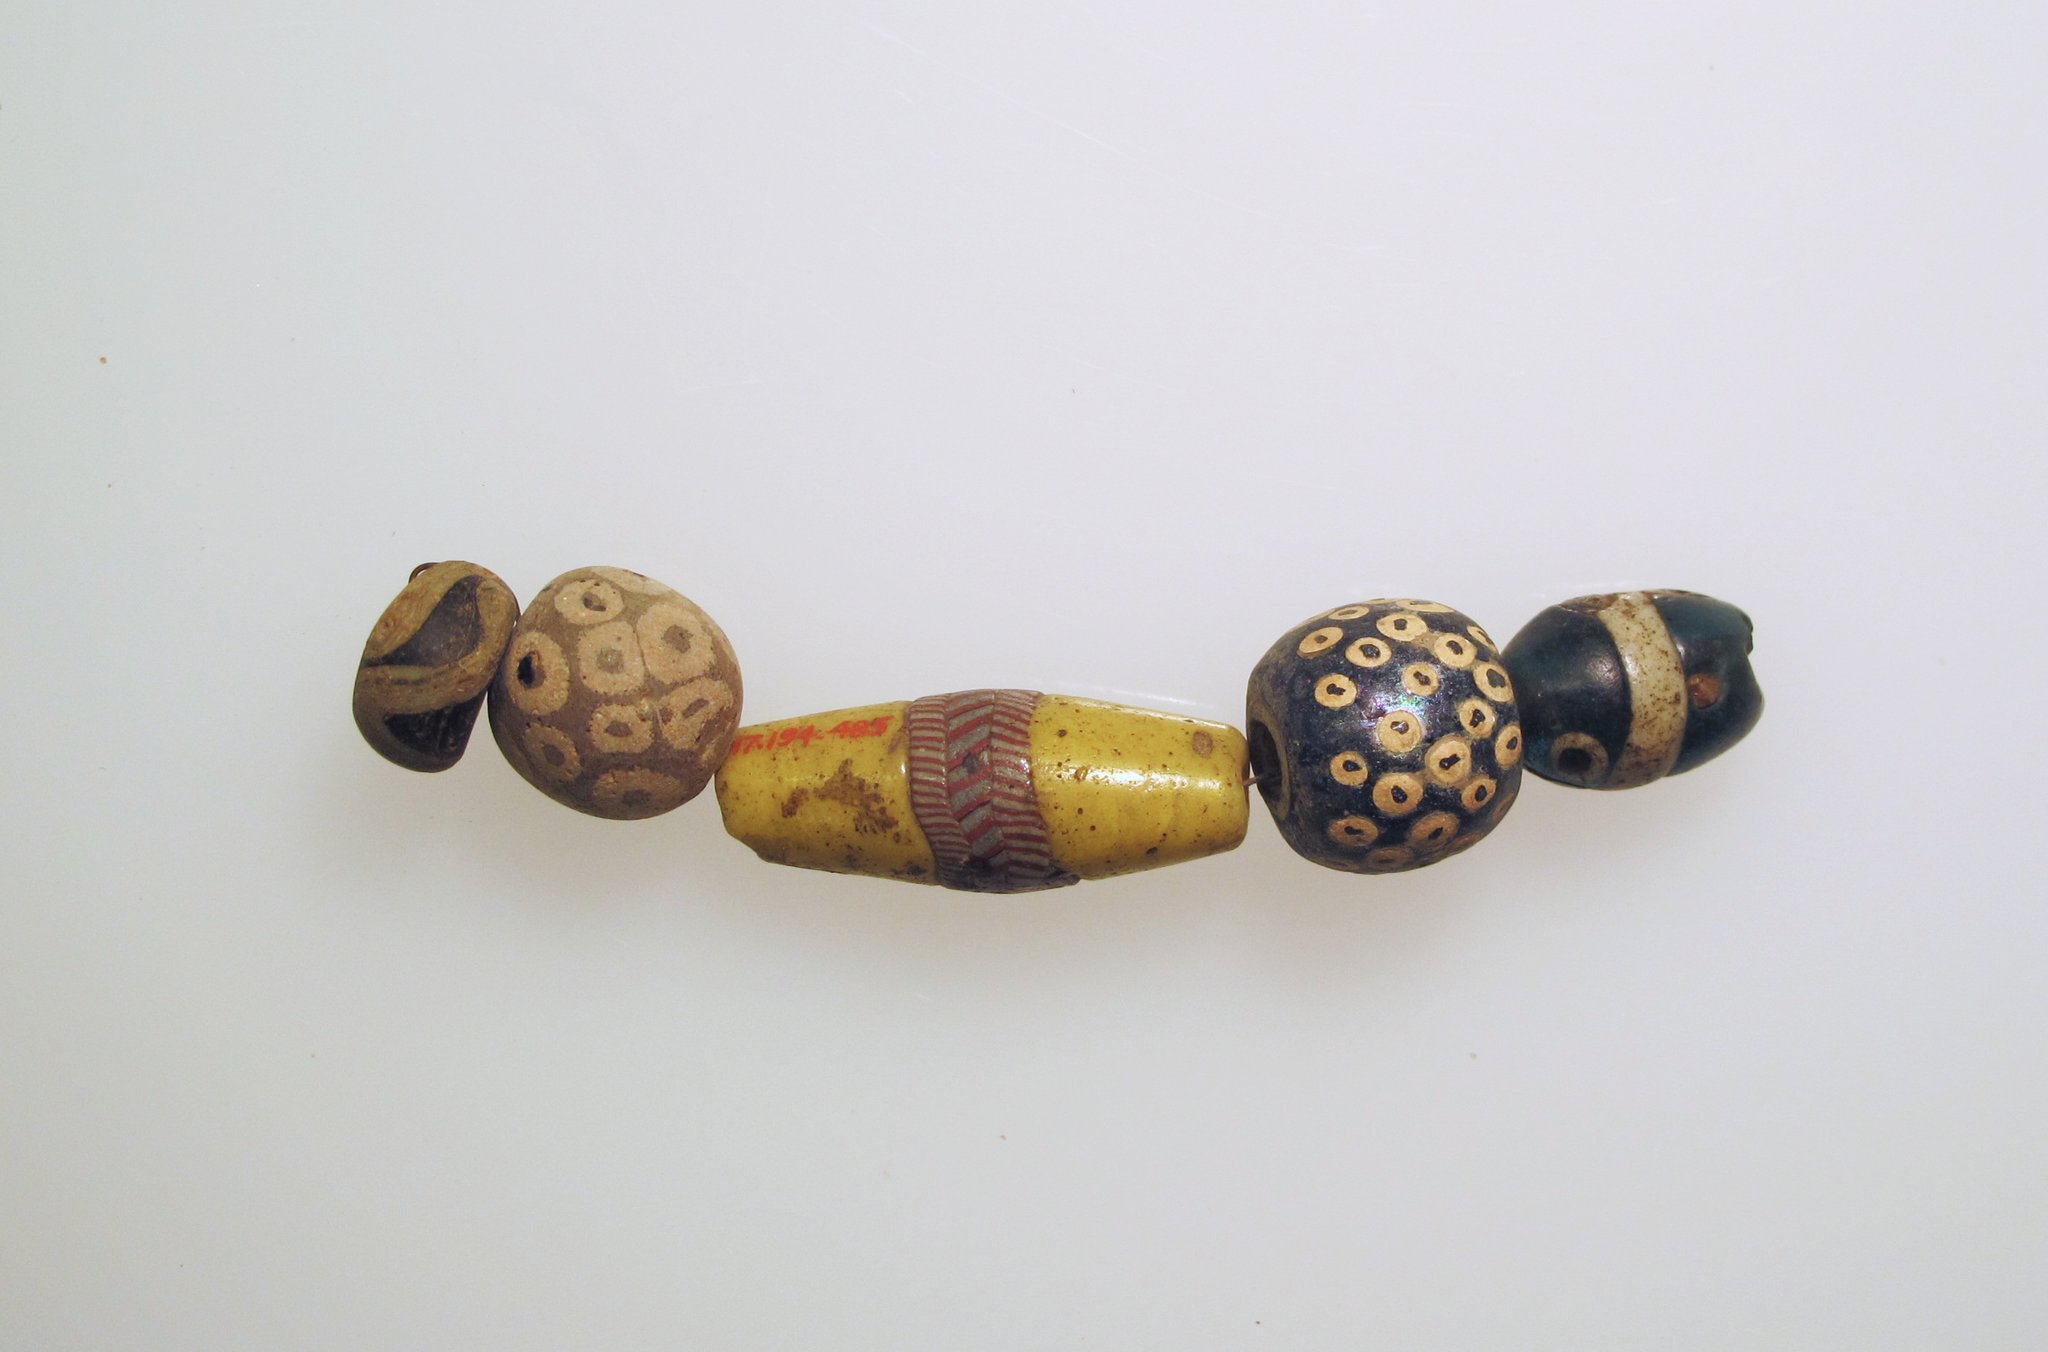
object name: bead, 5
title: Beads, 5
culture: roman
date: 670 BCE-330 CE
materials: glass